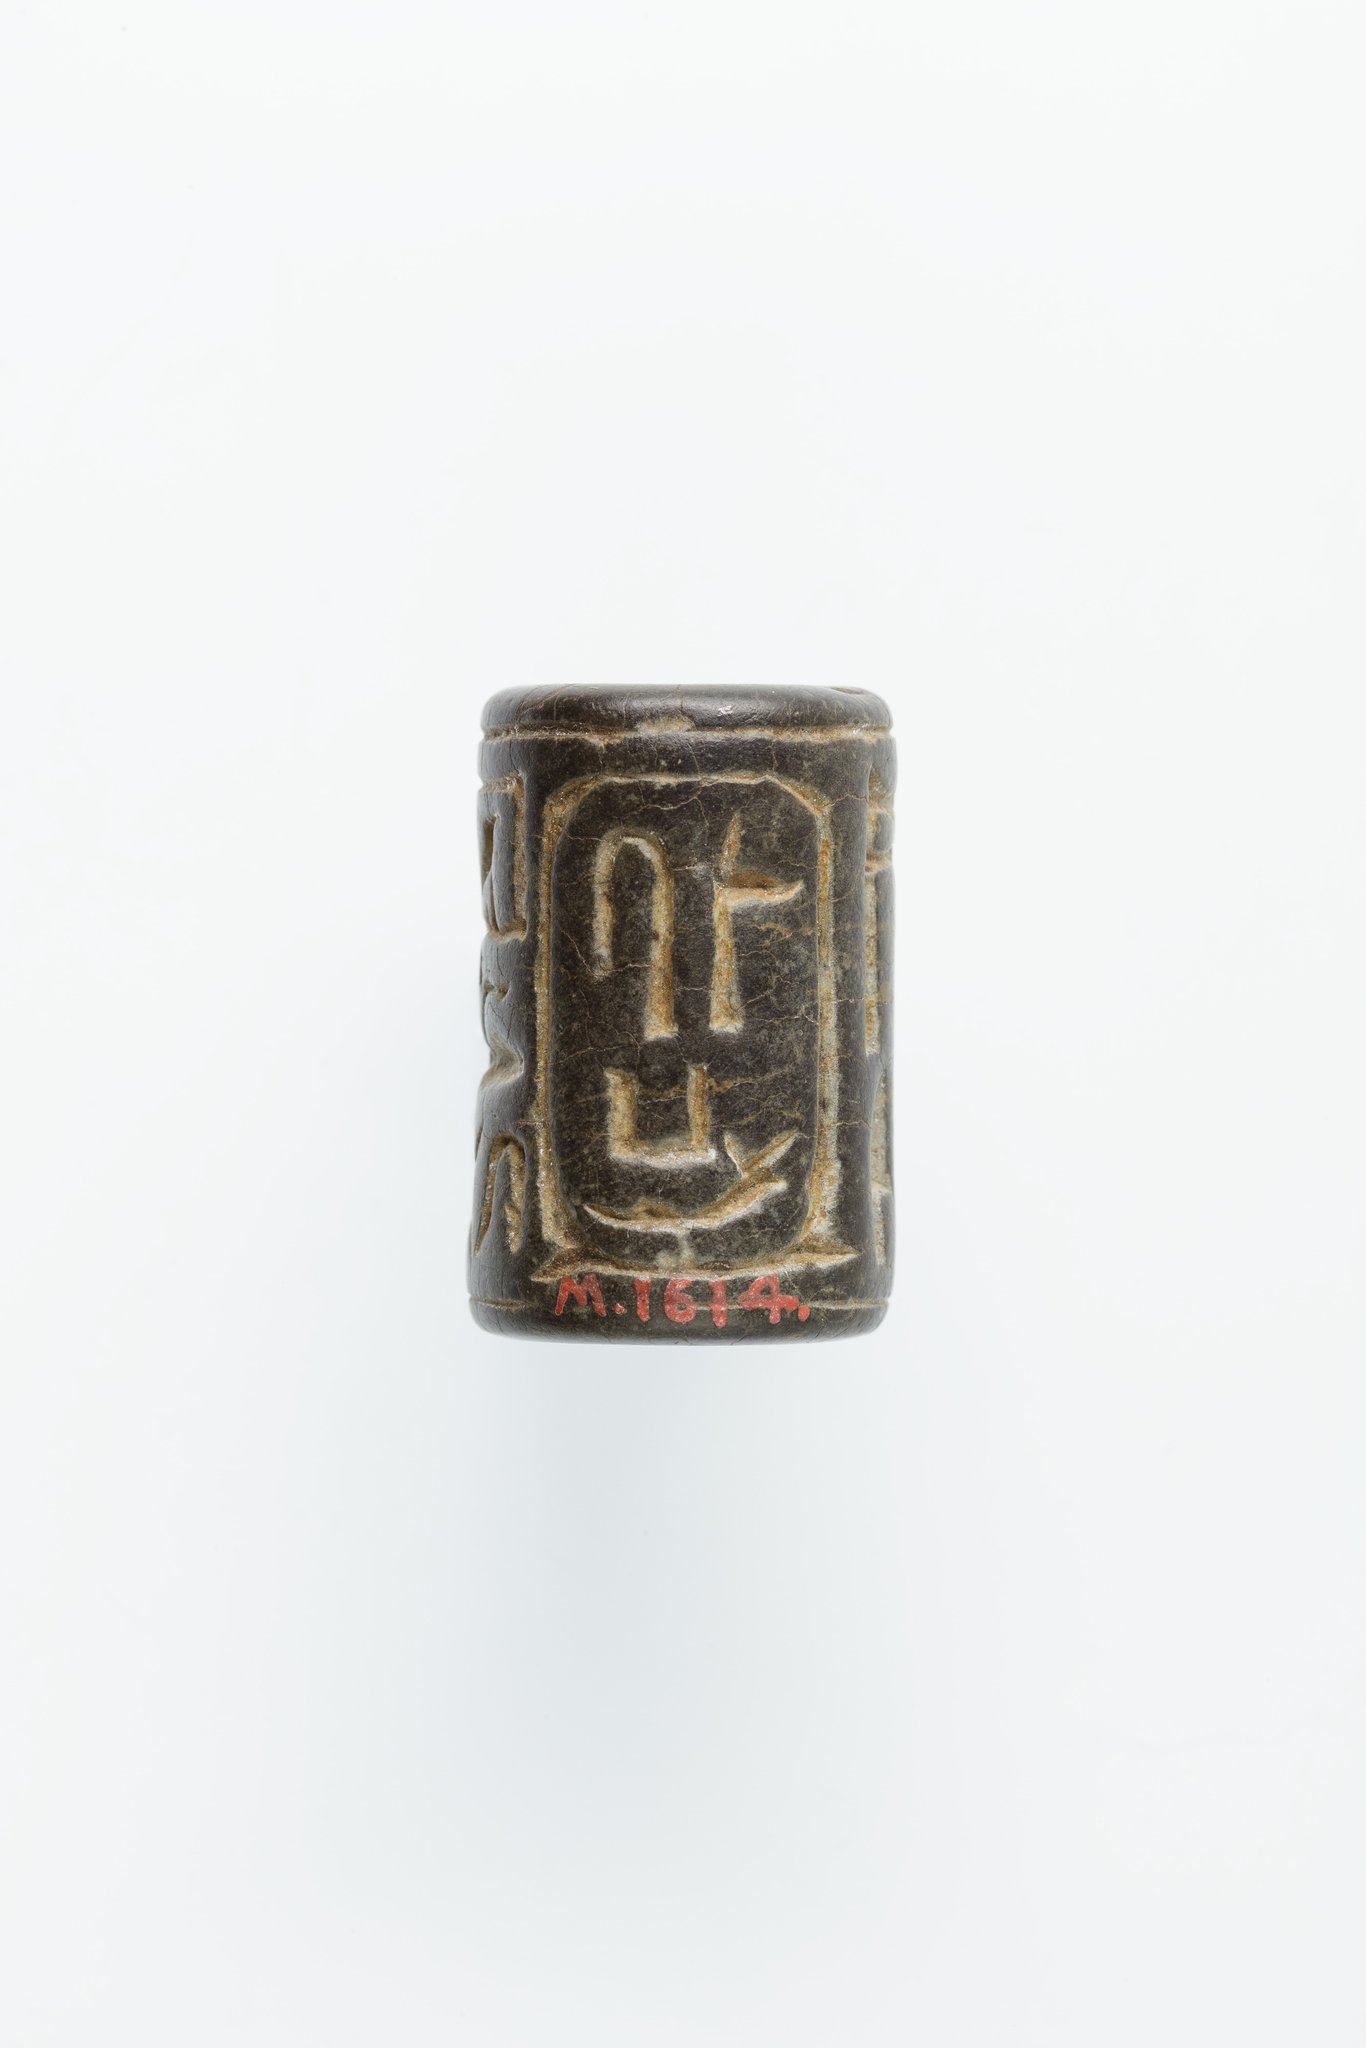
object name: cylinder seal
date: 2649-2100 BCE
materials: stone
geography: egypt